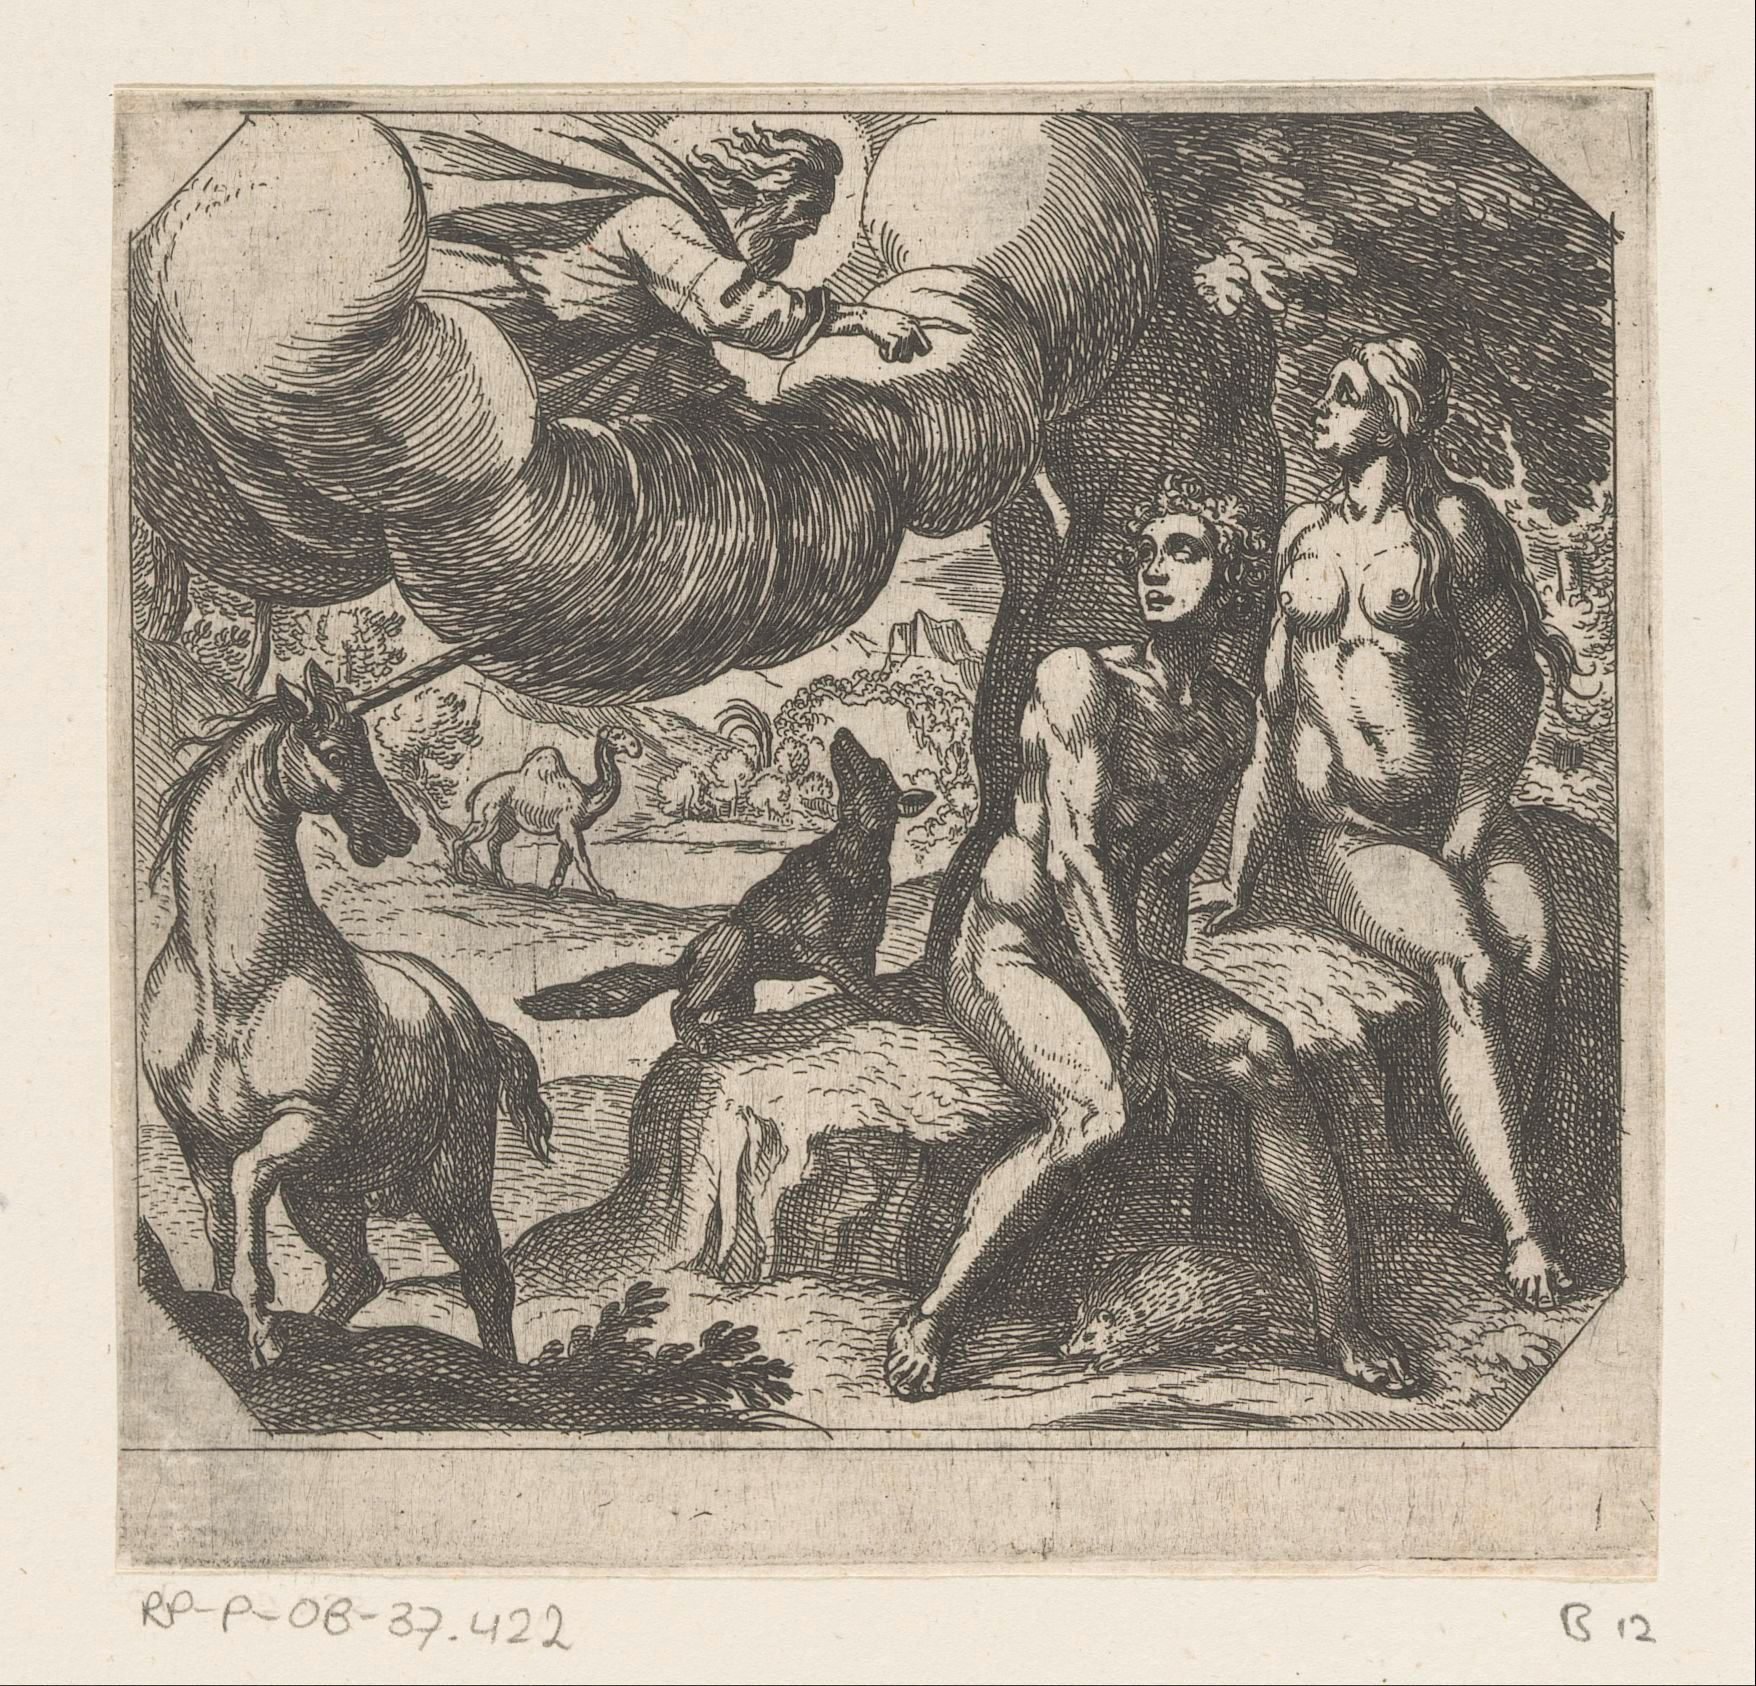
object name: print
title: De schepping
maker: antonio tempesta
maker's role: draughtsman, painter, print maker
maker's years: 1555-1630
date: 1565-1630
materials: paper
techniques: etching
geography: rome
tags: temptation and fall (scenes with both adam and eve)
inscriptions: collector's mark: Lugt 240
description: Deze prent maakt deel uit van een serie van twaalf prenten van de schepping. De prenten zijn deels naar ontwerpen van Rafaël voor de Loggia van Rafaël in het Vaticaan, en deels naar prenten door Nicolaes de Bruyn naar ontwerpen van Maerten de Vos (zie: Holl. Dutch. vol. 45 nr. 1-10).